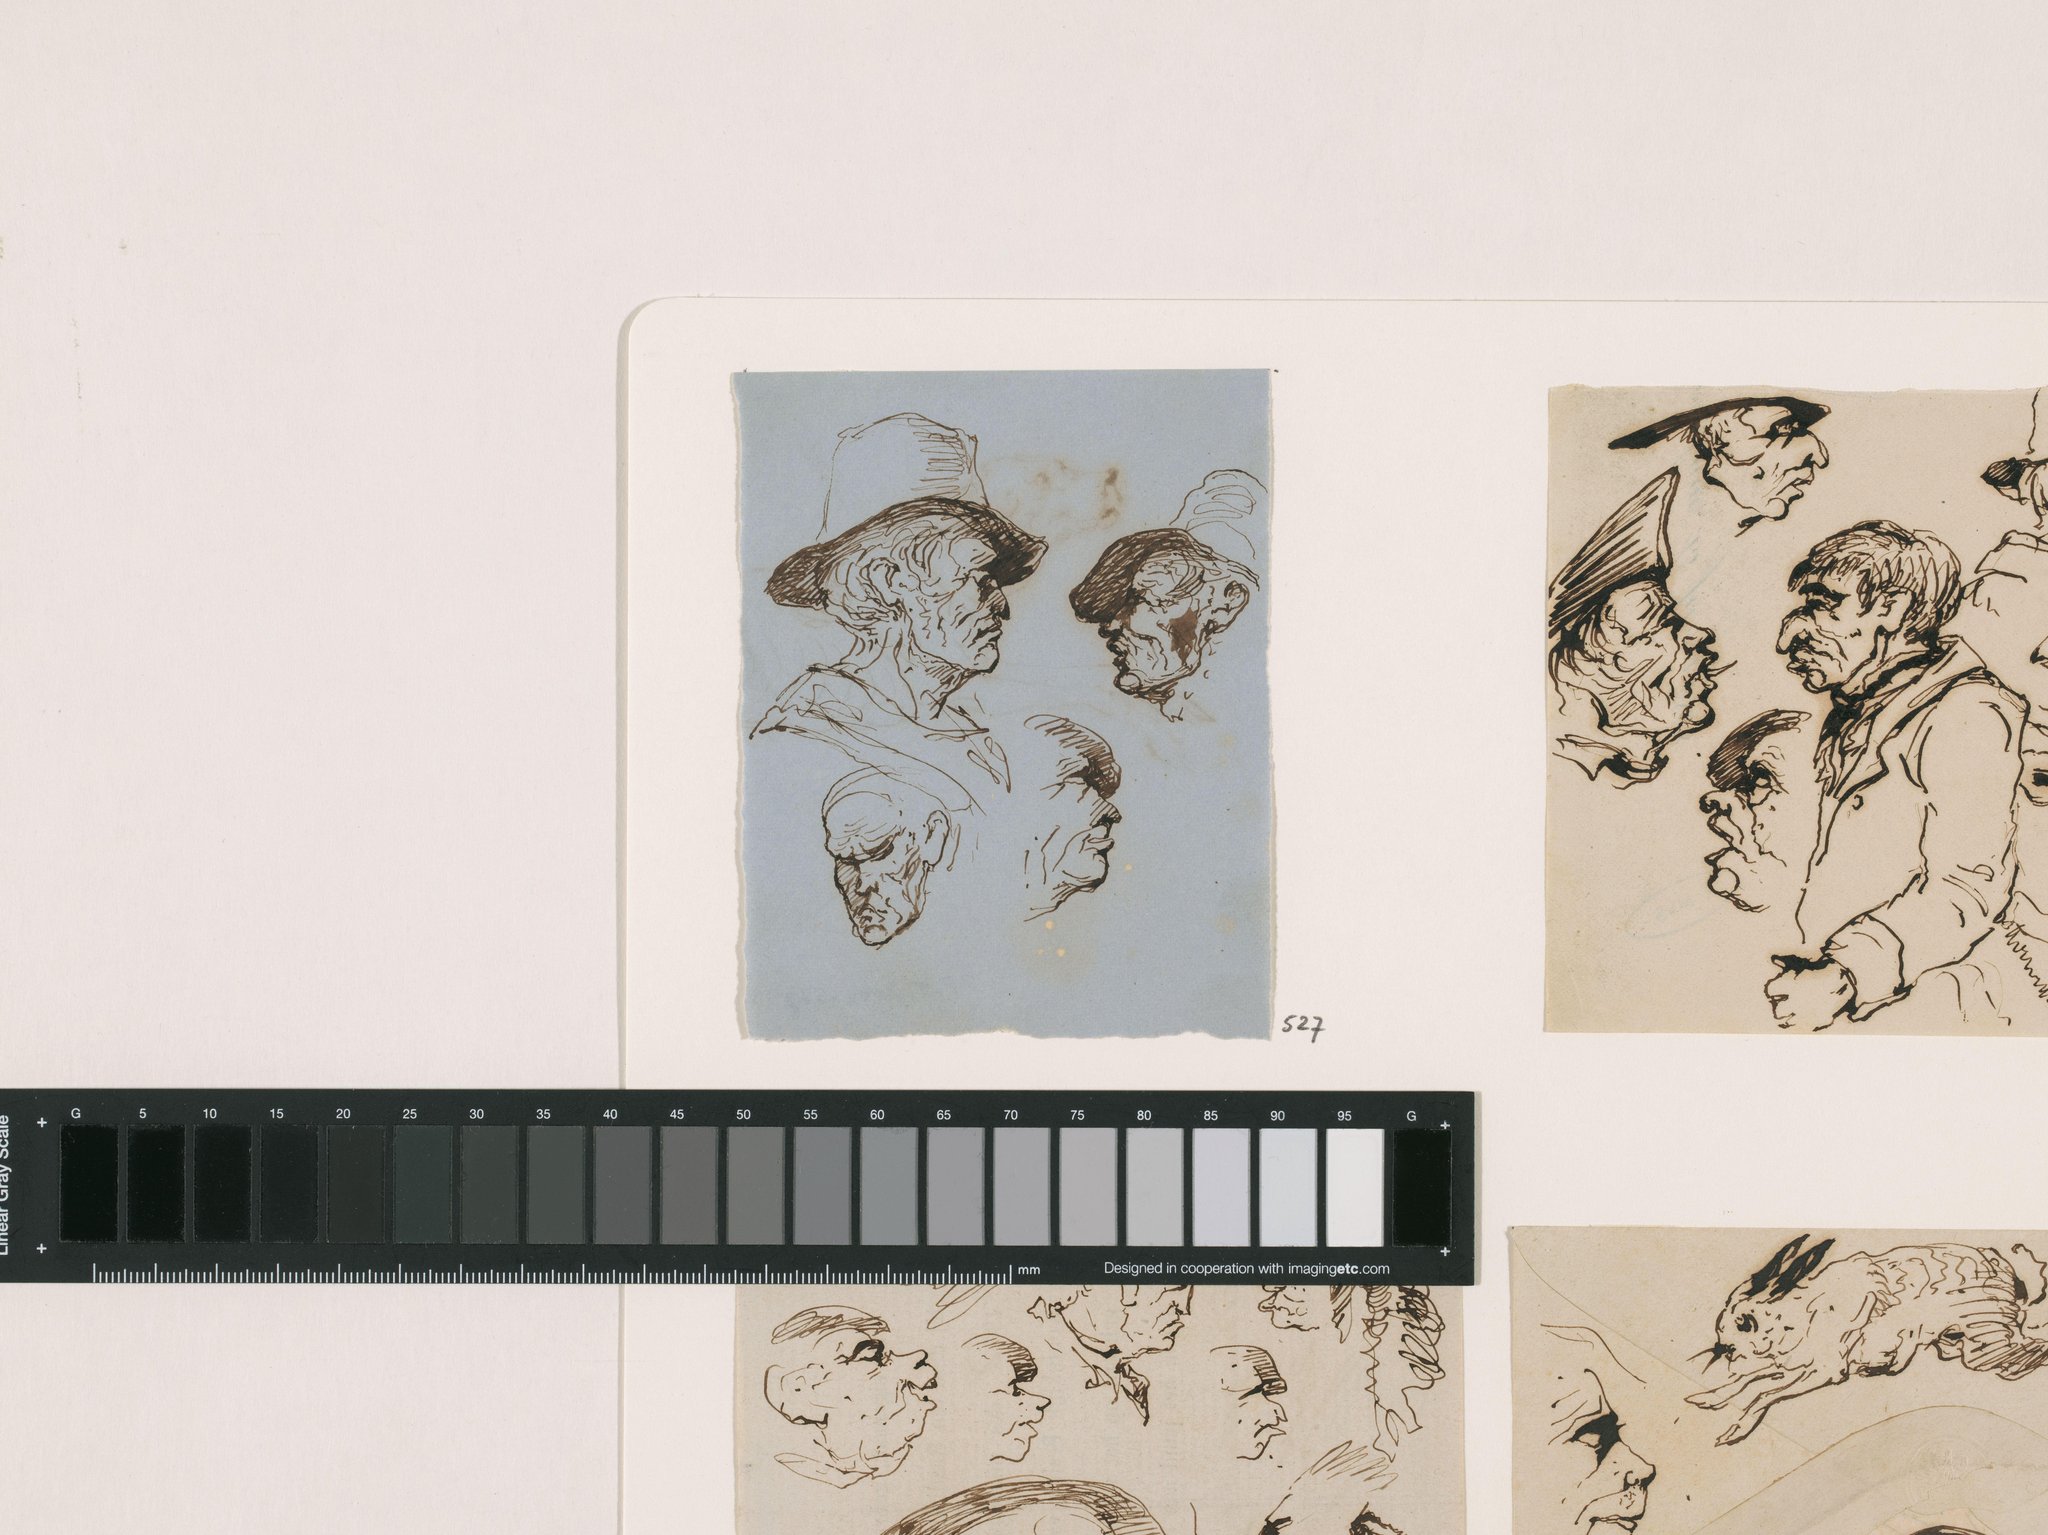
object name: drawing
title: Vier koppen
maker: johannes tavenraat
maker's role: draughtsman, painter, print maker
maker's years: 1809-1881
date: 1840-1880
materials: ink, paper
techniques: pen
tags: head (human), caricatures (human types)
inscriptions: collector's mark: Lugt 2228